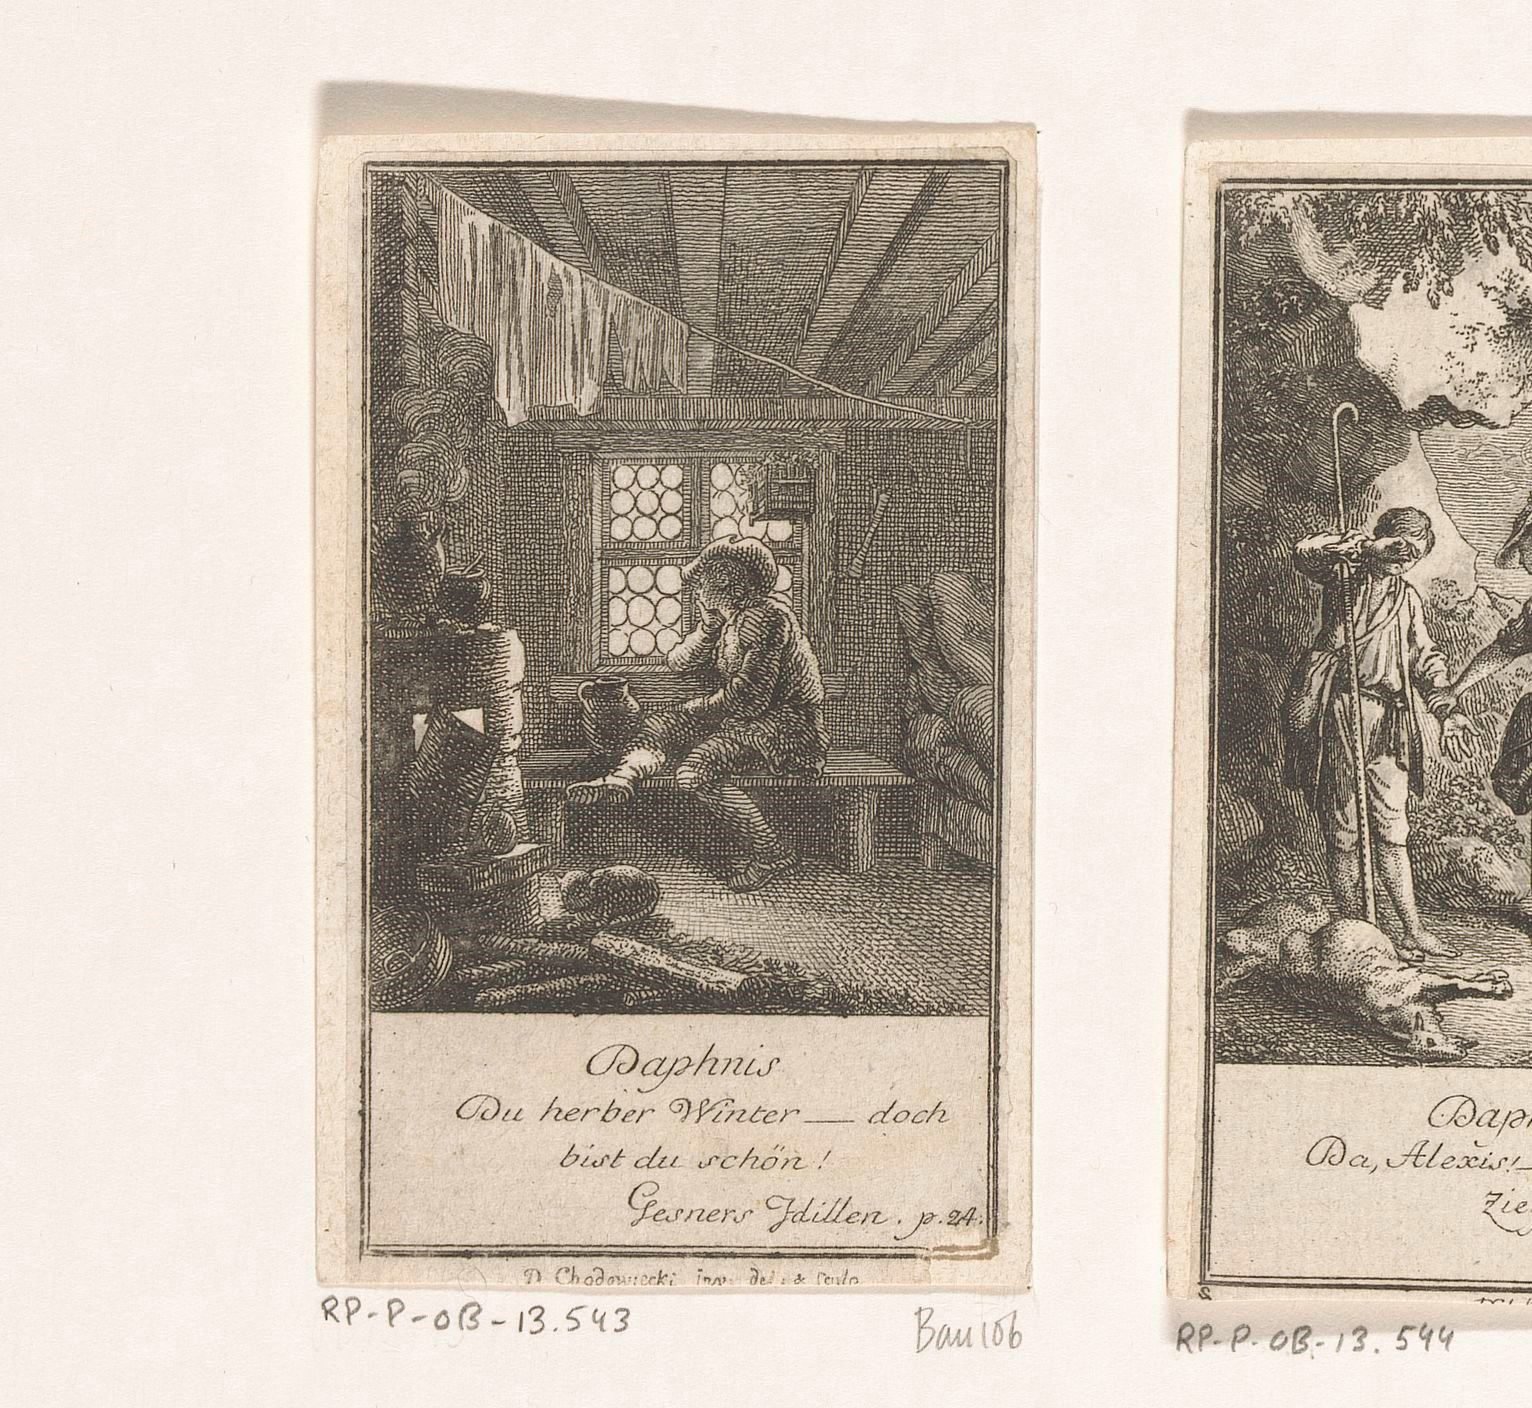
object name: print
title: Daphnis kijkt uit het raam op een wintermorgen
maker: daniel nikolaus chodowiecki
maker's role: draughtsman, print maker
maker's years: 1726-1801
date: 1771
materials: paper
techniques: etching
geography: berlin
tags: painter, print maker, salomon gessner, daphnis (in greek mythology a shepherd who invented pastoral poetry, human figure at (open) window, seen from inside, pastorals, arcadian scenes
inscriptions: collector's mark: Lugt 2228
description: Eerste prent afkomstig uit een serie met twaalf scènes die 'Idyllen' van Salomon Gessner illustreren. De twaalf scènes werden samen op een plaat geëtst. De serie is gebruikt als illustratie in: 'Berliner genealogischen Calender auf das Jahr 1773'.